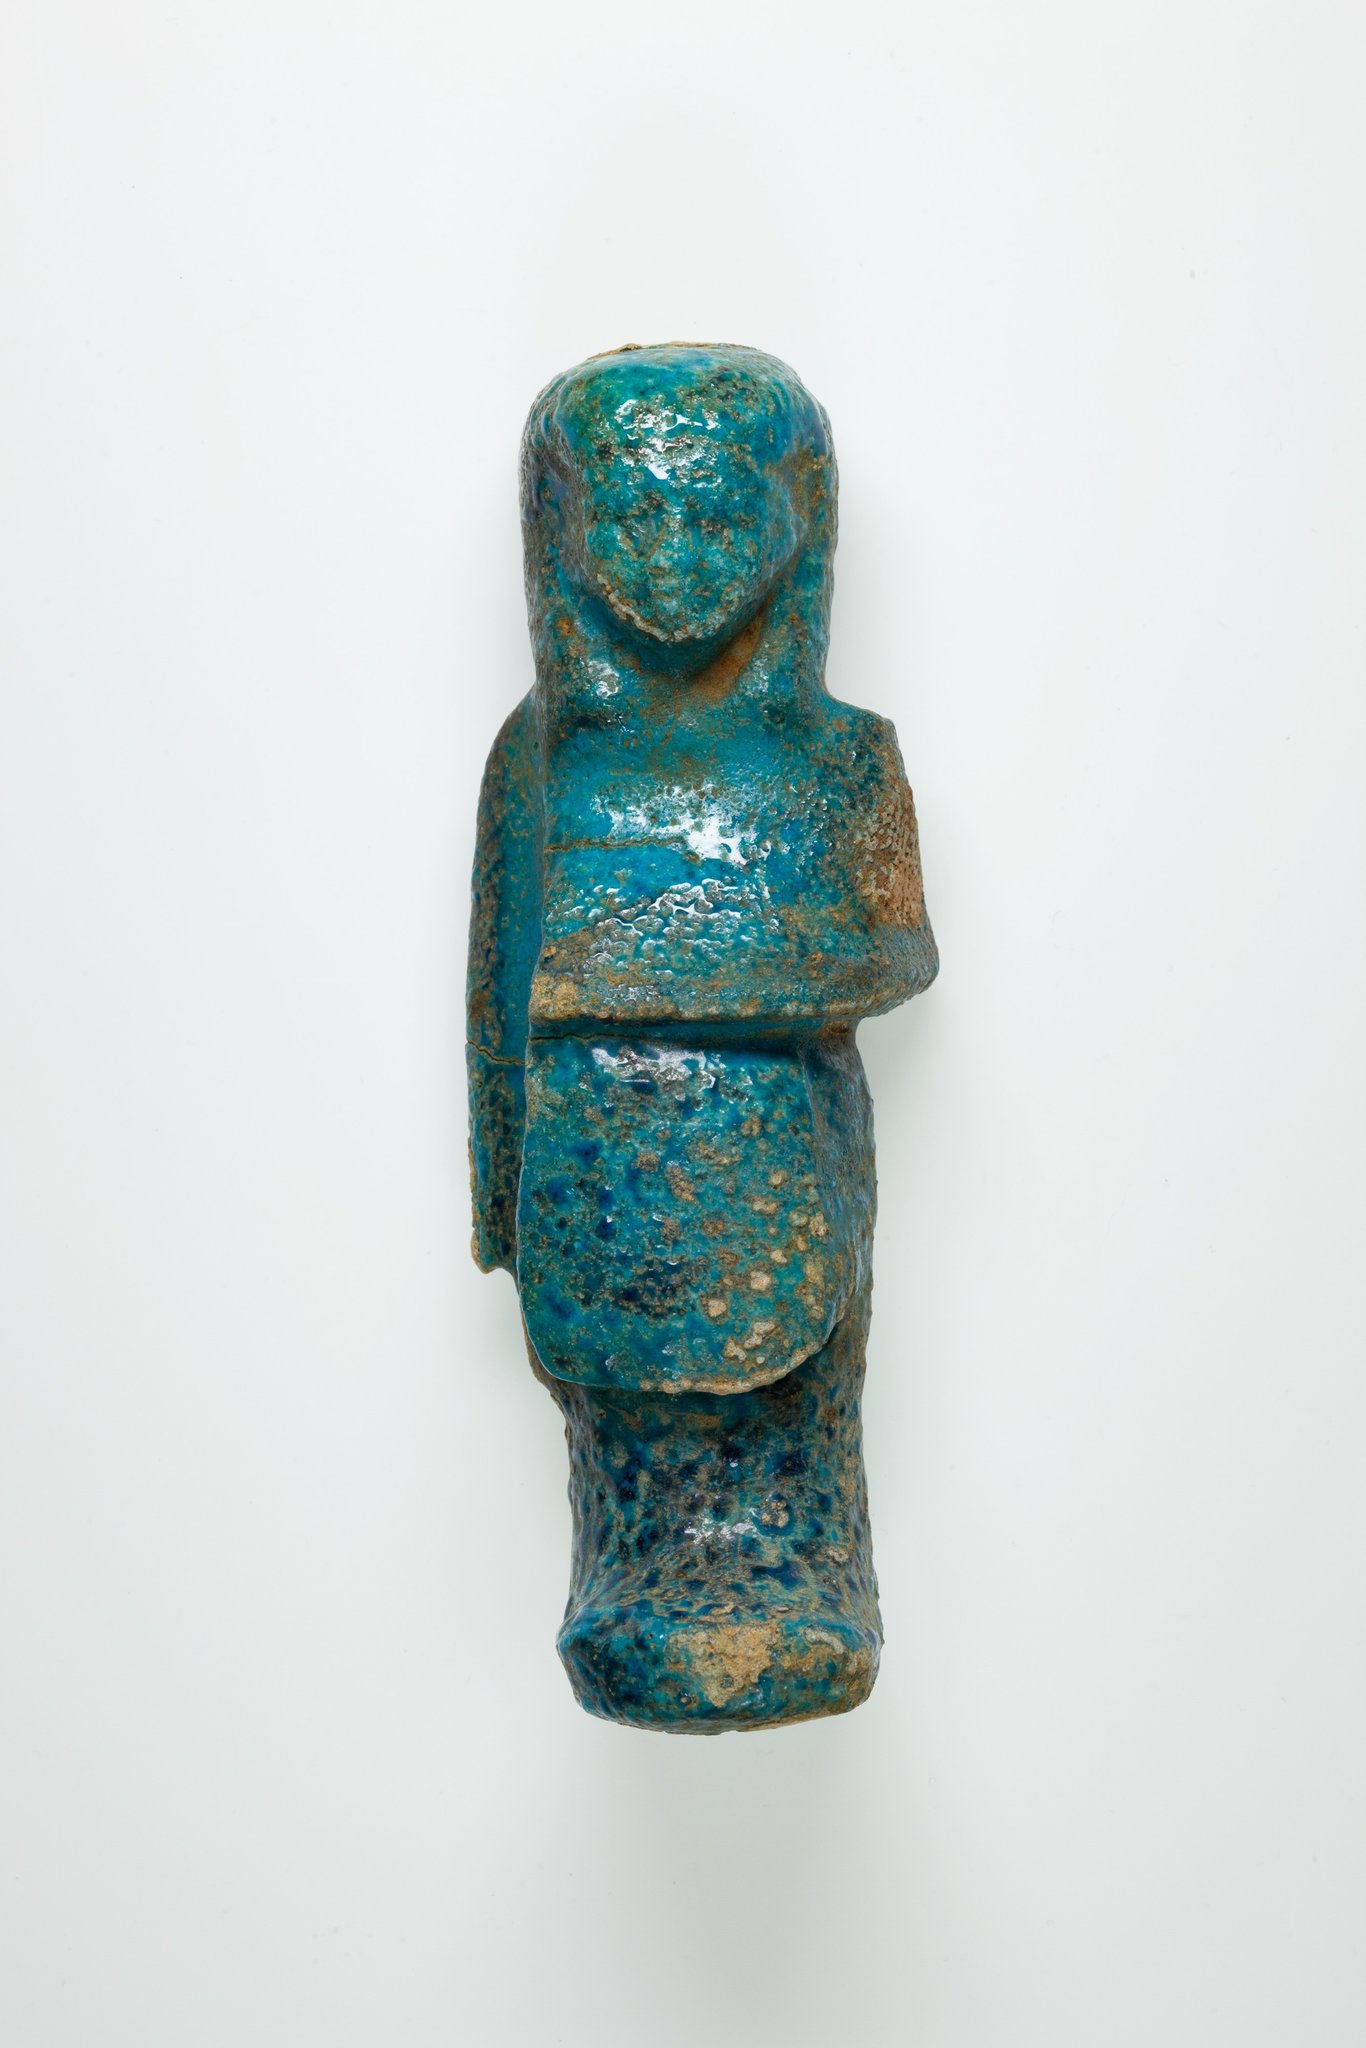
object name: overseer shabti, henettawy c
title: Overseer Shabti of Henettawy (C), Daughter of Isetemkheb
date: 990-970 BCE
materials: faience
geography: egypt